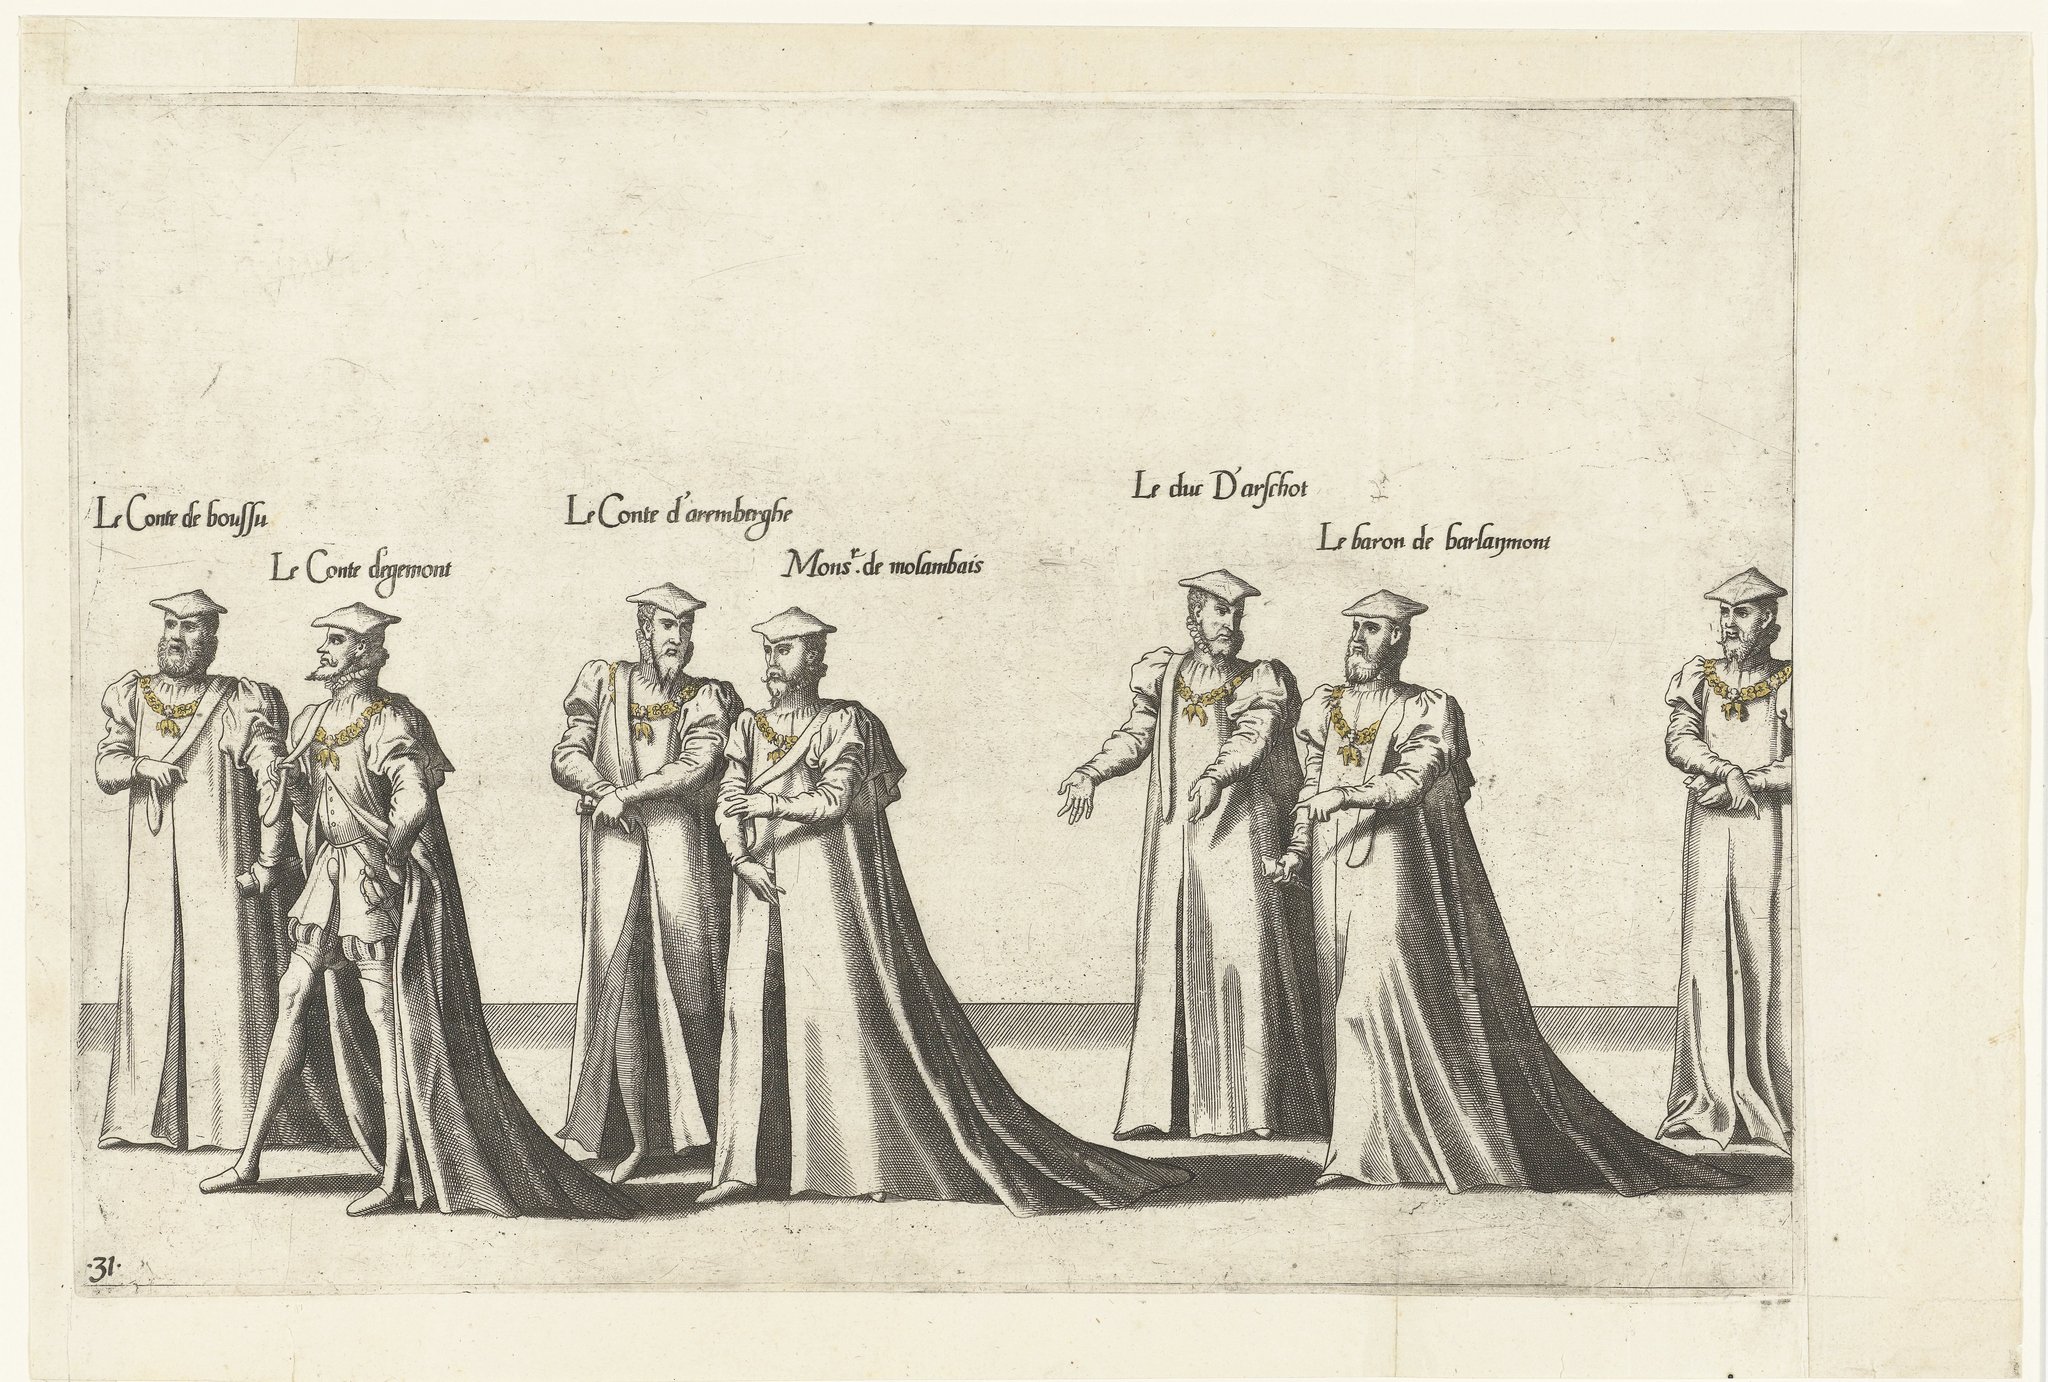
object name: print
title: Begrafenisoptocht van keizer Karel V, 1558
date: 1559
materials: paper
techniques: engraving, etching, hand coloring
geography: southern netherlands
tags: maastricht, antwerp, jean de ligne (duke of arenberg), bergen op zoom, politician, ghent, charles v (holy roman emperor and king of spain), venice, earl, brussels, cortege, funeral procession, knighthood order of the golden fleece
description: Zeven vliesridders die deelnemen aan de optocht. Onderdeel van de prentreeks van de Begrafenisoptocht van keizer Karel V op 29 december 1558 te Brussel.